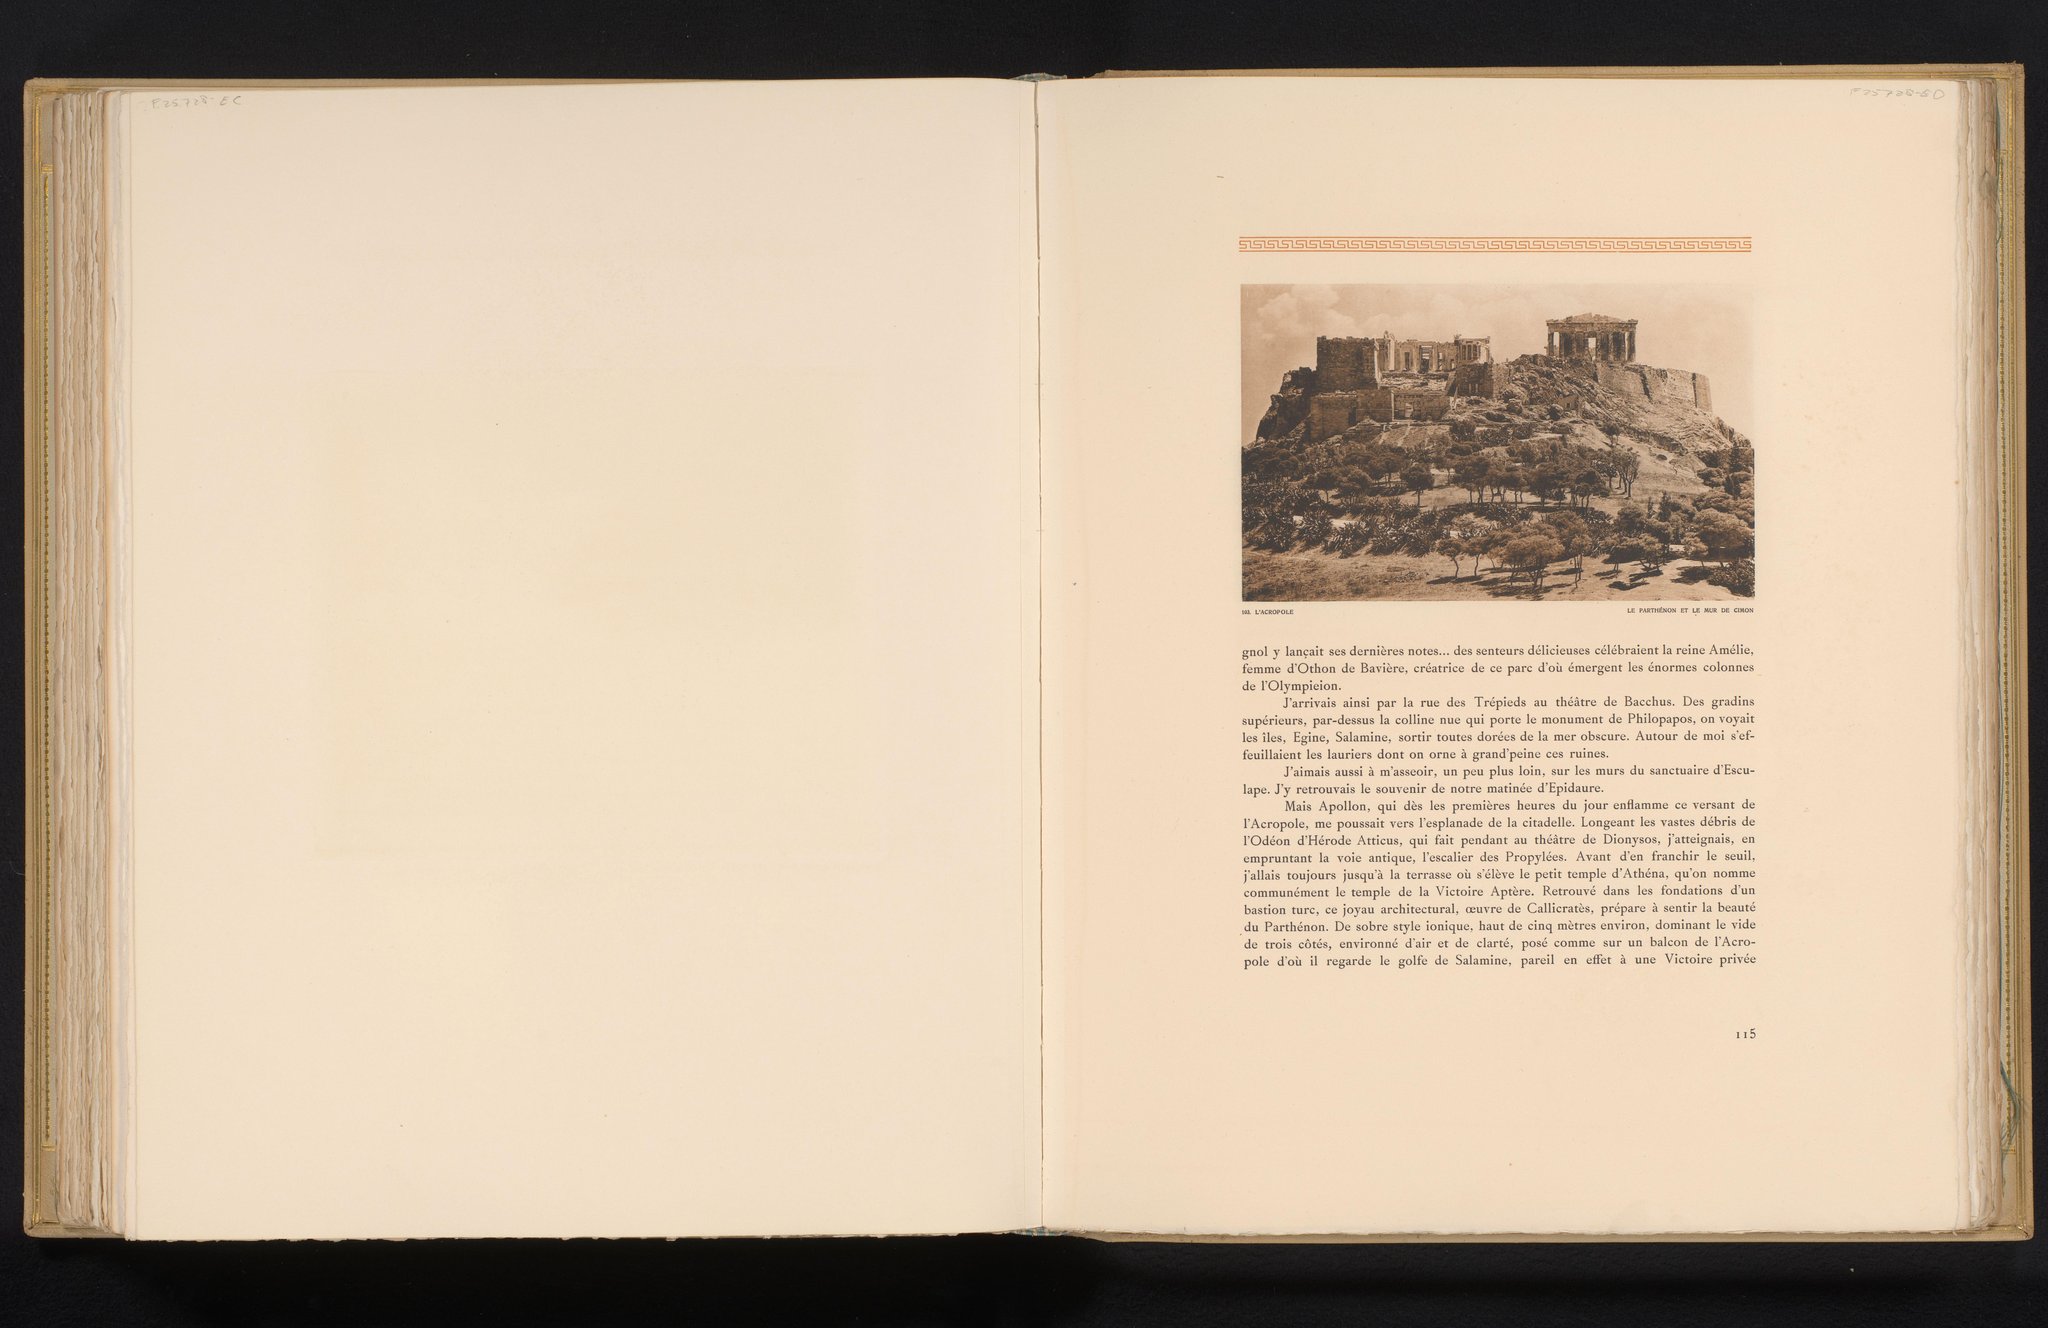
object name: photomechanical print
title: Gezicht op het Parthenon op de akropolis van Athene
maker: frédéric boissonnas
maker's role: fotograaf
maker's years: 1858-1946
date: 1905-1910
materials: paper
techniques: photograph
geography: berlin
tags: temple, shrine ~ greek religion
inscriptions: number: ‘103.’